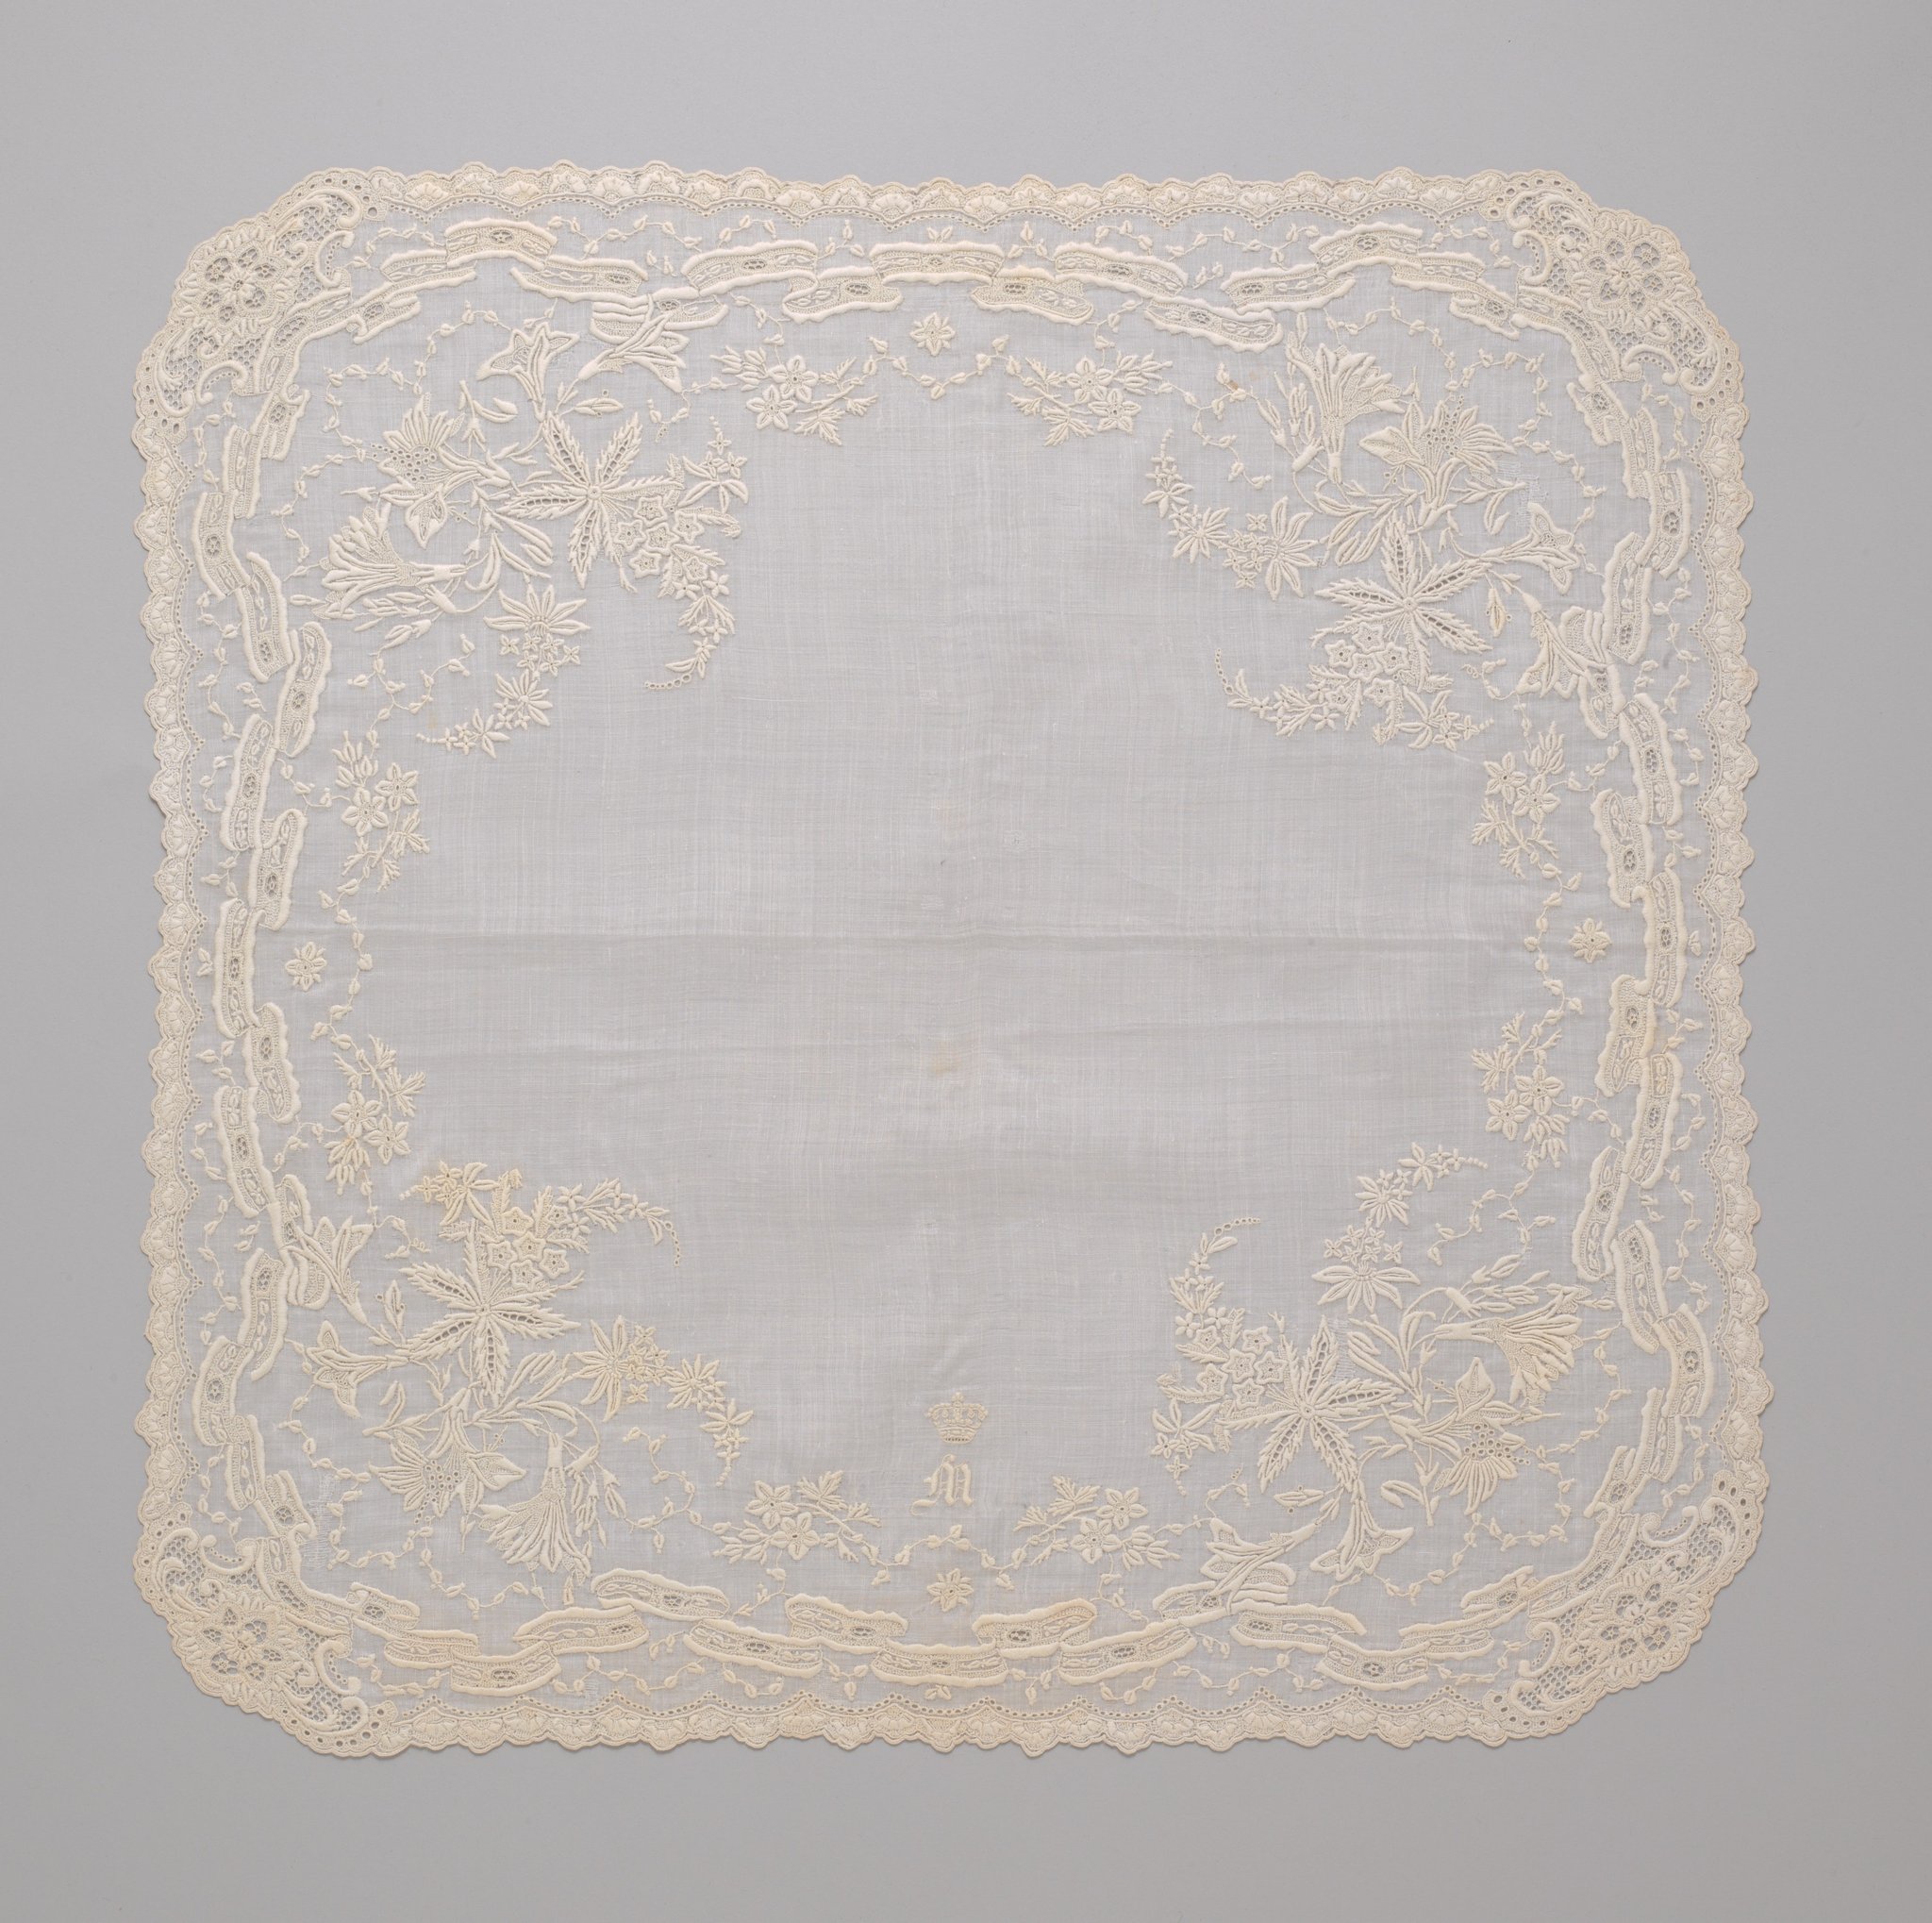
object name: handkerchief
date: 1840-1880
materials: linen, silk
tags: flowers